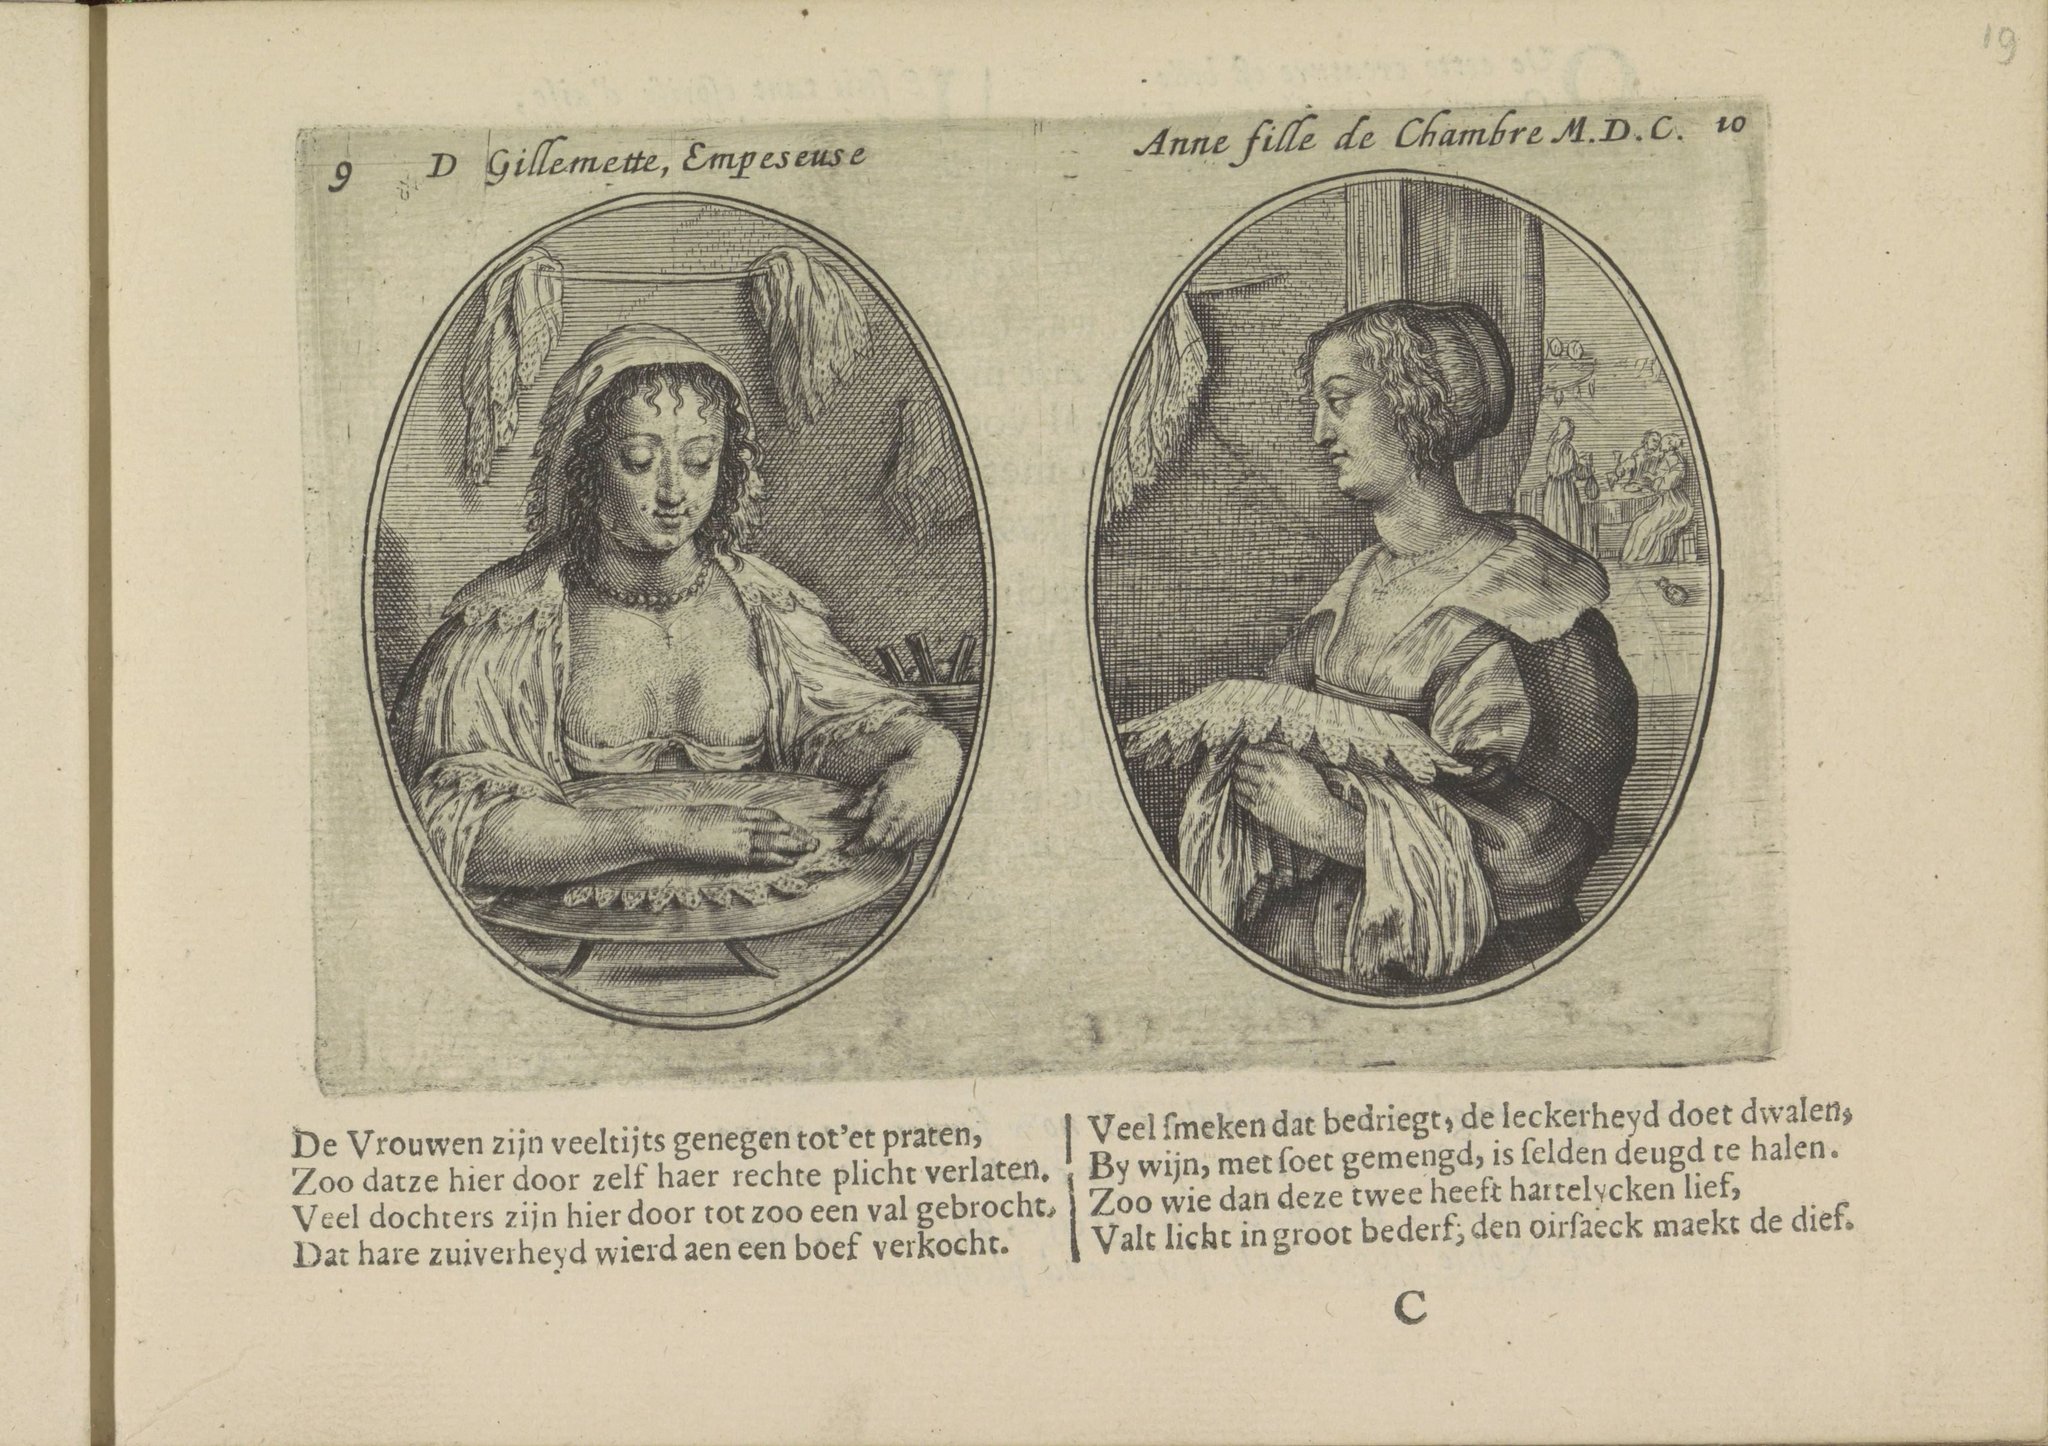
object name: album leaf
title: Stijfster en kamenierster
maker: crispijn van de passe (ii)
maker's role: draughtsman, print maker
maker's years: 1594-1670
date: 1641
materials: paper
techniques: engraving, letterpress printing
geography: amsterdam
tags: servant - aa - chambermaid, female sex; woman, couple of lovers, neck-gear: collar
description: Twee voorstellingen op een albumblad. Links het fictieve portret van een stijfster genaamd Willemijn. Ze stijft een kanten kraag, uitgelegd op een rond plateau. Rechts een kamenierster genaamd Anneke met een kanten kraag in haar handen. Op de achtergrond een verliefd stelletje aan een gedekte tafel. Daarnaast een bediende en een kat. Daaronder twee kwatrijnen in het Nederlands. De prent maakt deel uit van een album.